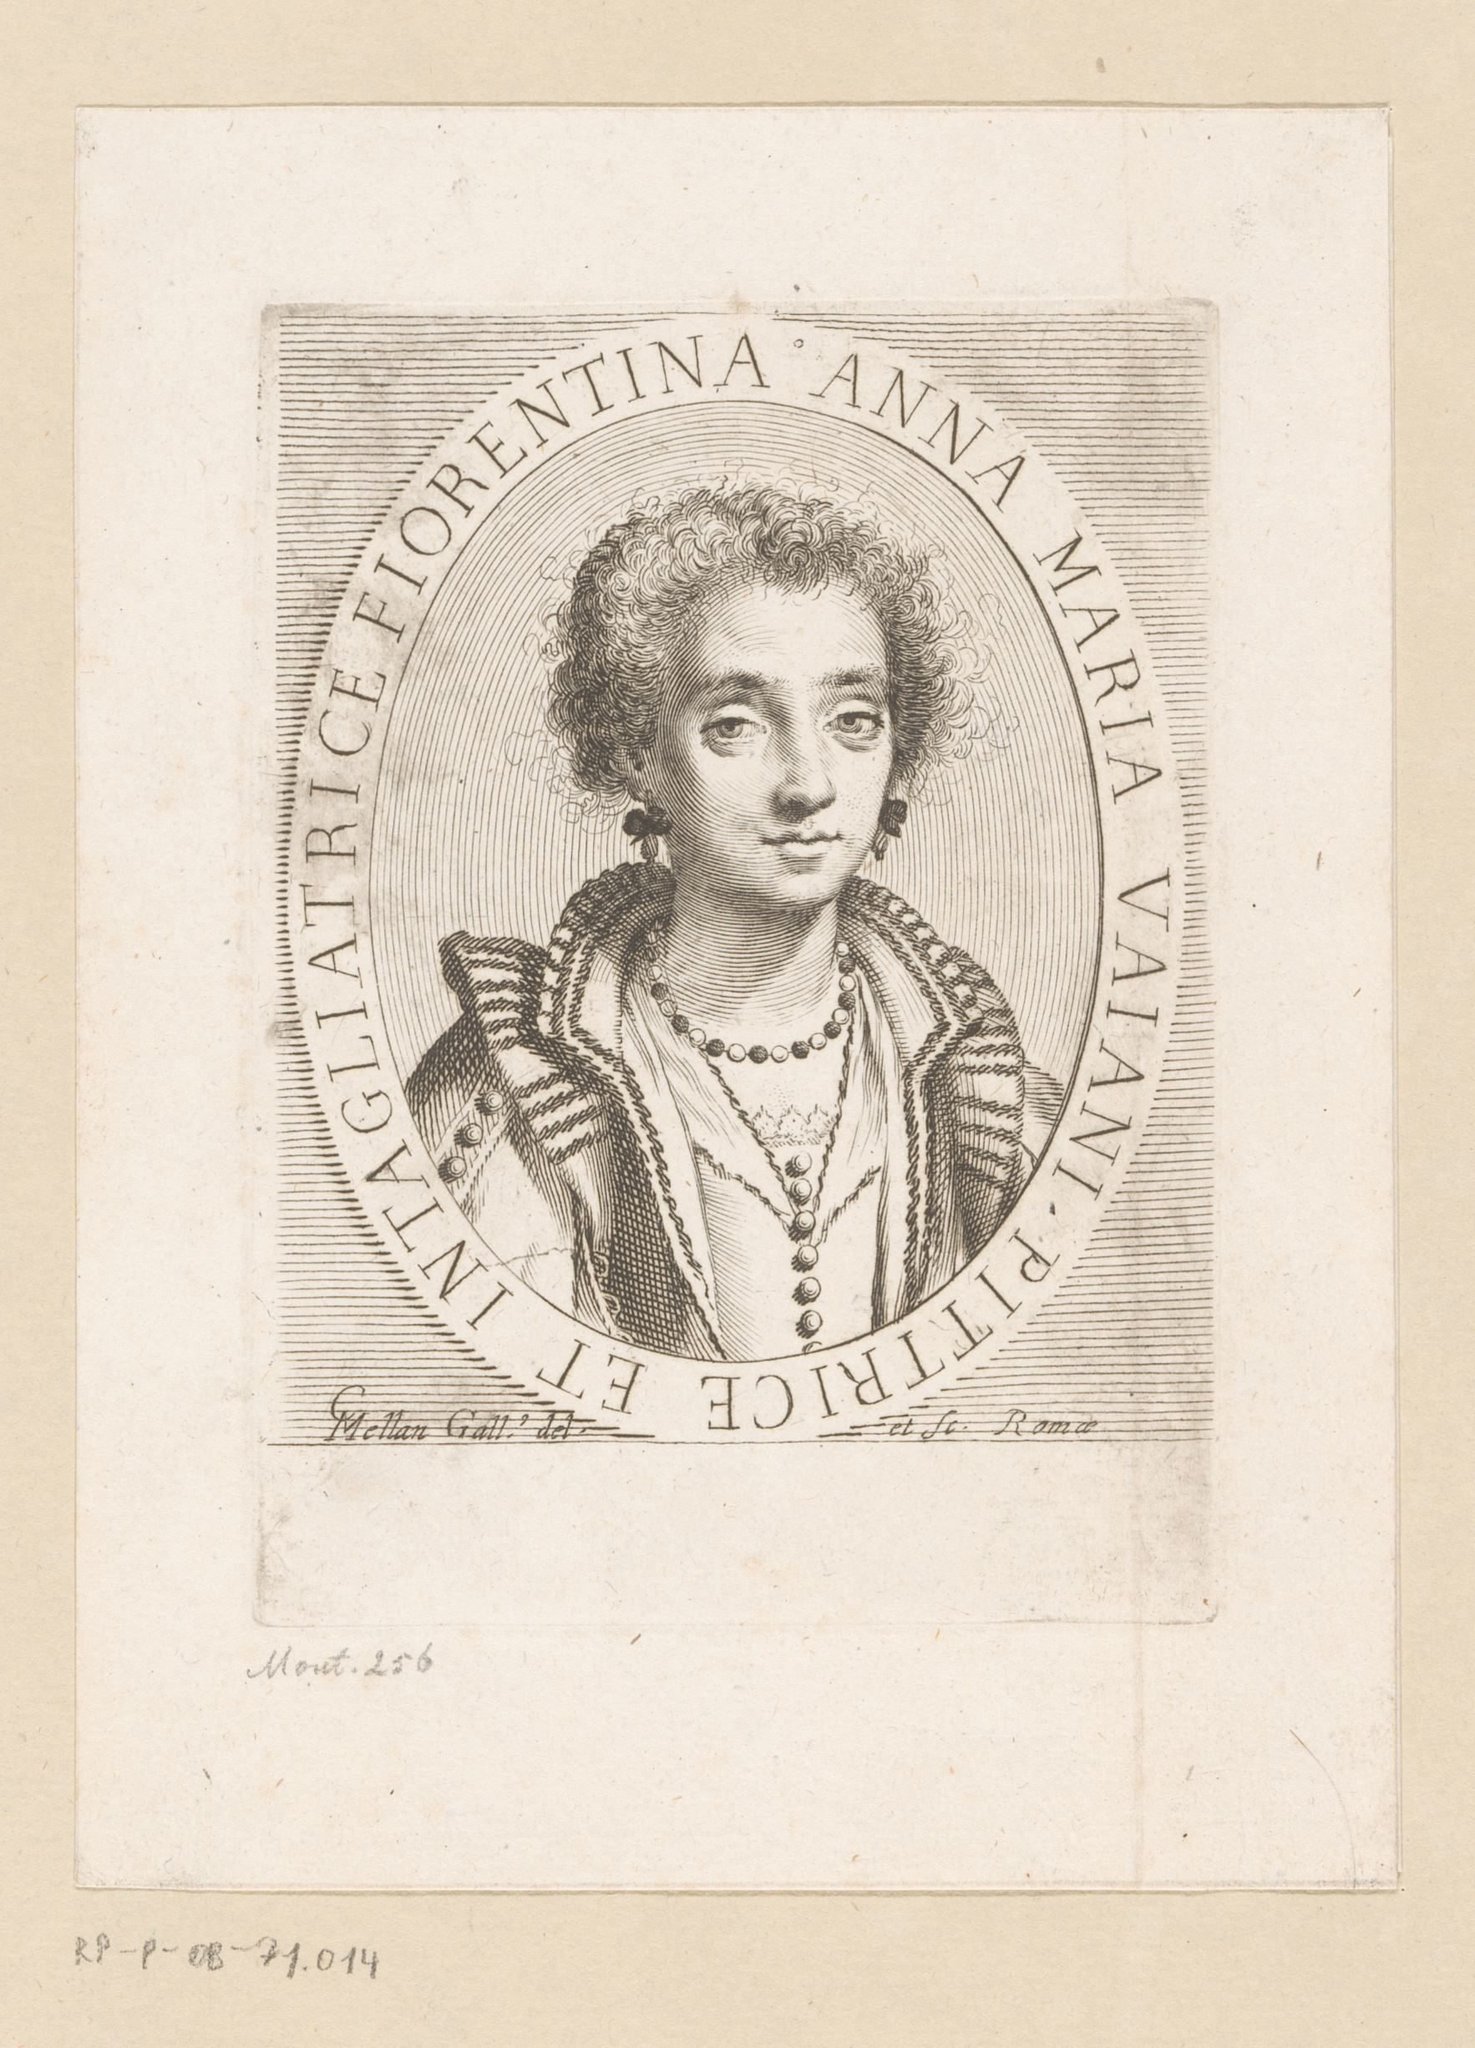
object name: print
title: Portret van Anna Maria Vaiani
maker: claude mellan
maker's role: draughtsman, print maker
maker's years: 1598-1688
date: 1624-1636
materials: paper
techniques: engraving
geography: rome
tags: painter, print maker, draughtsman, historical persons - bb - woman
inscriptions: collector's mark: Lugt 2228